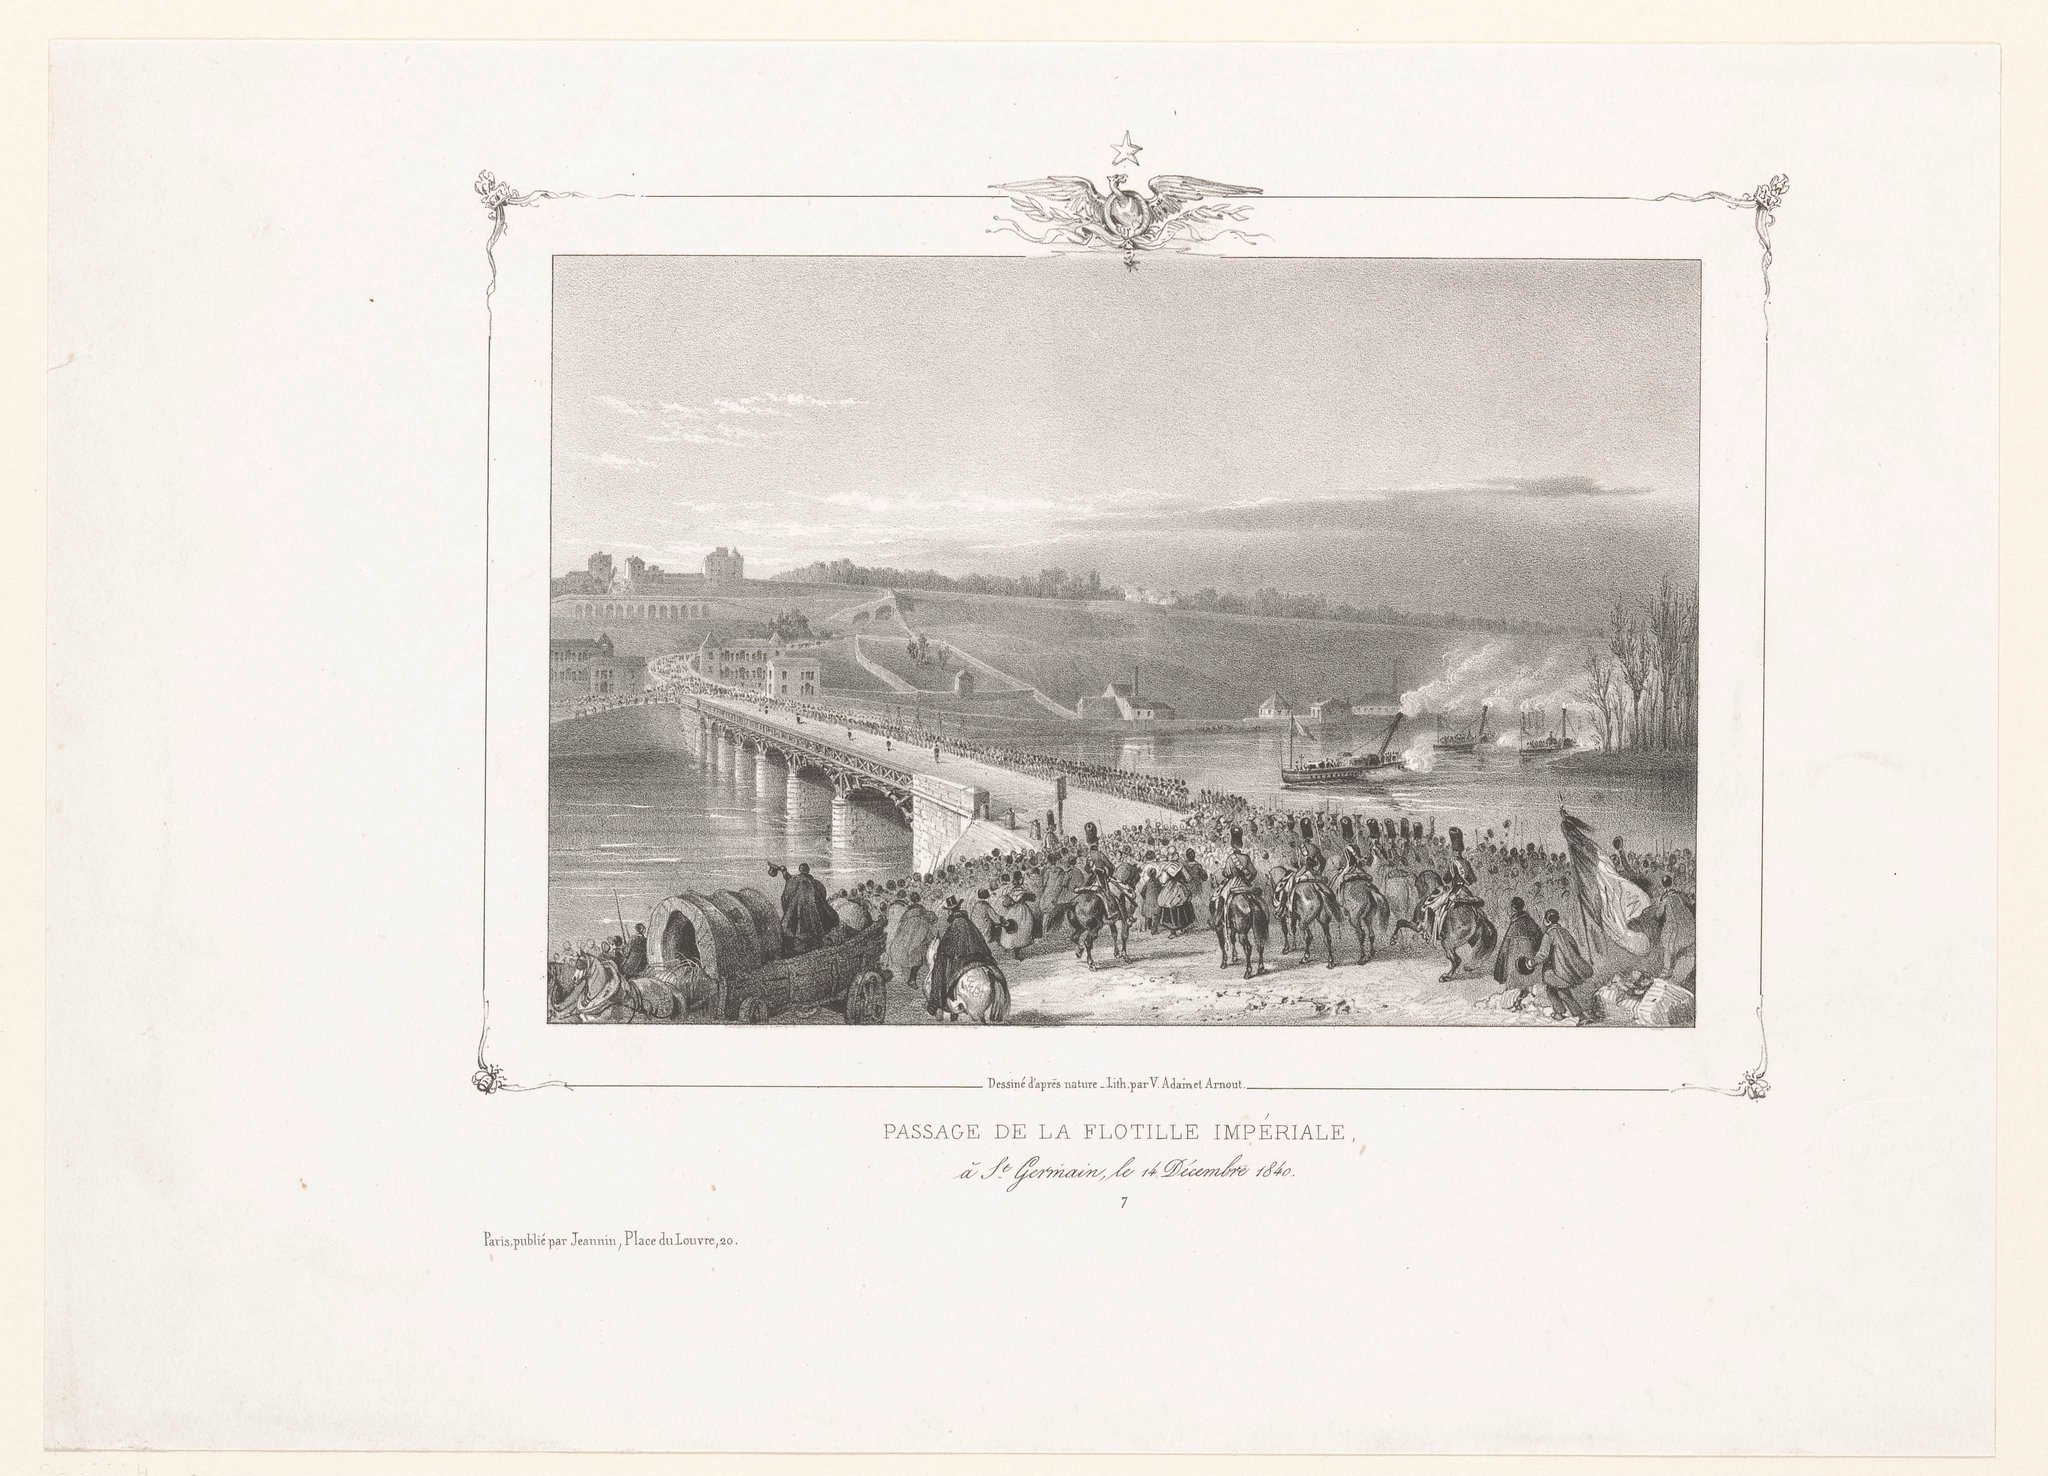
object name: print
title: Keizerlijke vloot passeert Saint-Germain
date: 1840-1841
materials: paper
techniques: lithograph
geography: paris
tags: napoleon i (emperor of the french), re-burial, ships (in general), coffin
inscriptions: stamp: Lugt 1397c, collector's mark: Lugt 2228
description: Deze serie bevat 24 prenten in klein formaat, die een vereenvoudiging zijn van eerder uitgegeven prenten in groot formaat. In 1840 werden de stoffelijke resten van Napoleon op initiatief van Adolphe Thiers en koning Louis-Philippe van Sint-Helena overgebracht naar Parijs (Le retour des cendres). De tekening voor de steendruk is naar het leven gemaakt ('dessiné d'après nature').